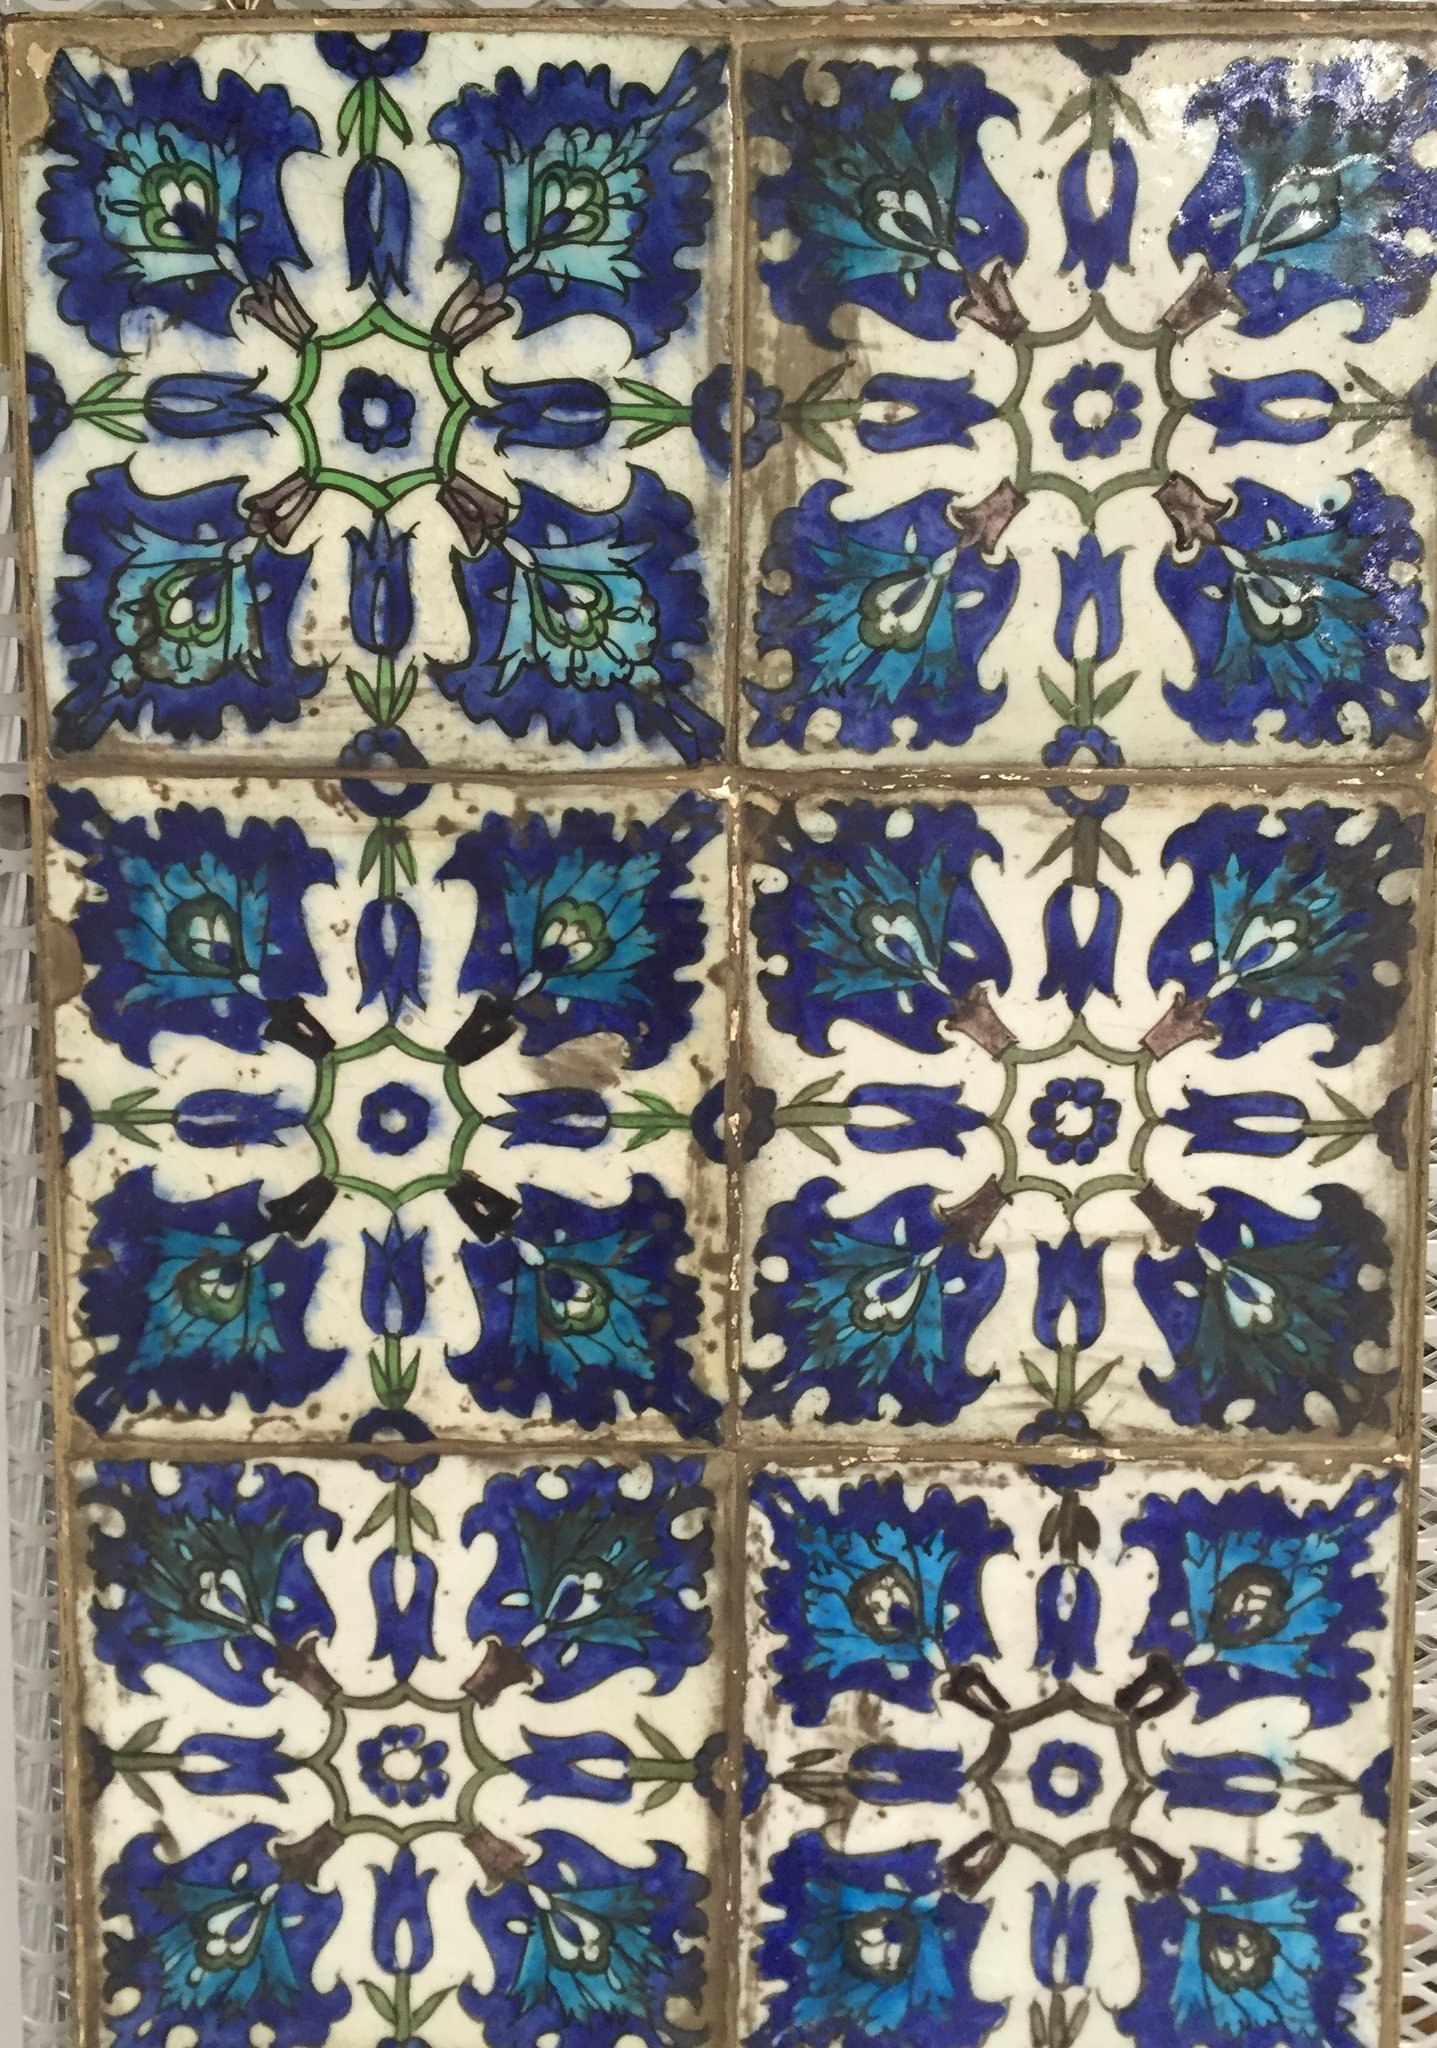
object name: tile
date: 1601-1650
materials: stonepaste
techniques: glazing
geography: syria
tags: flowers